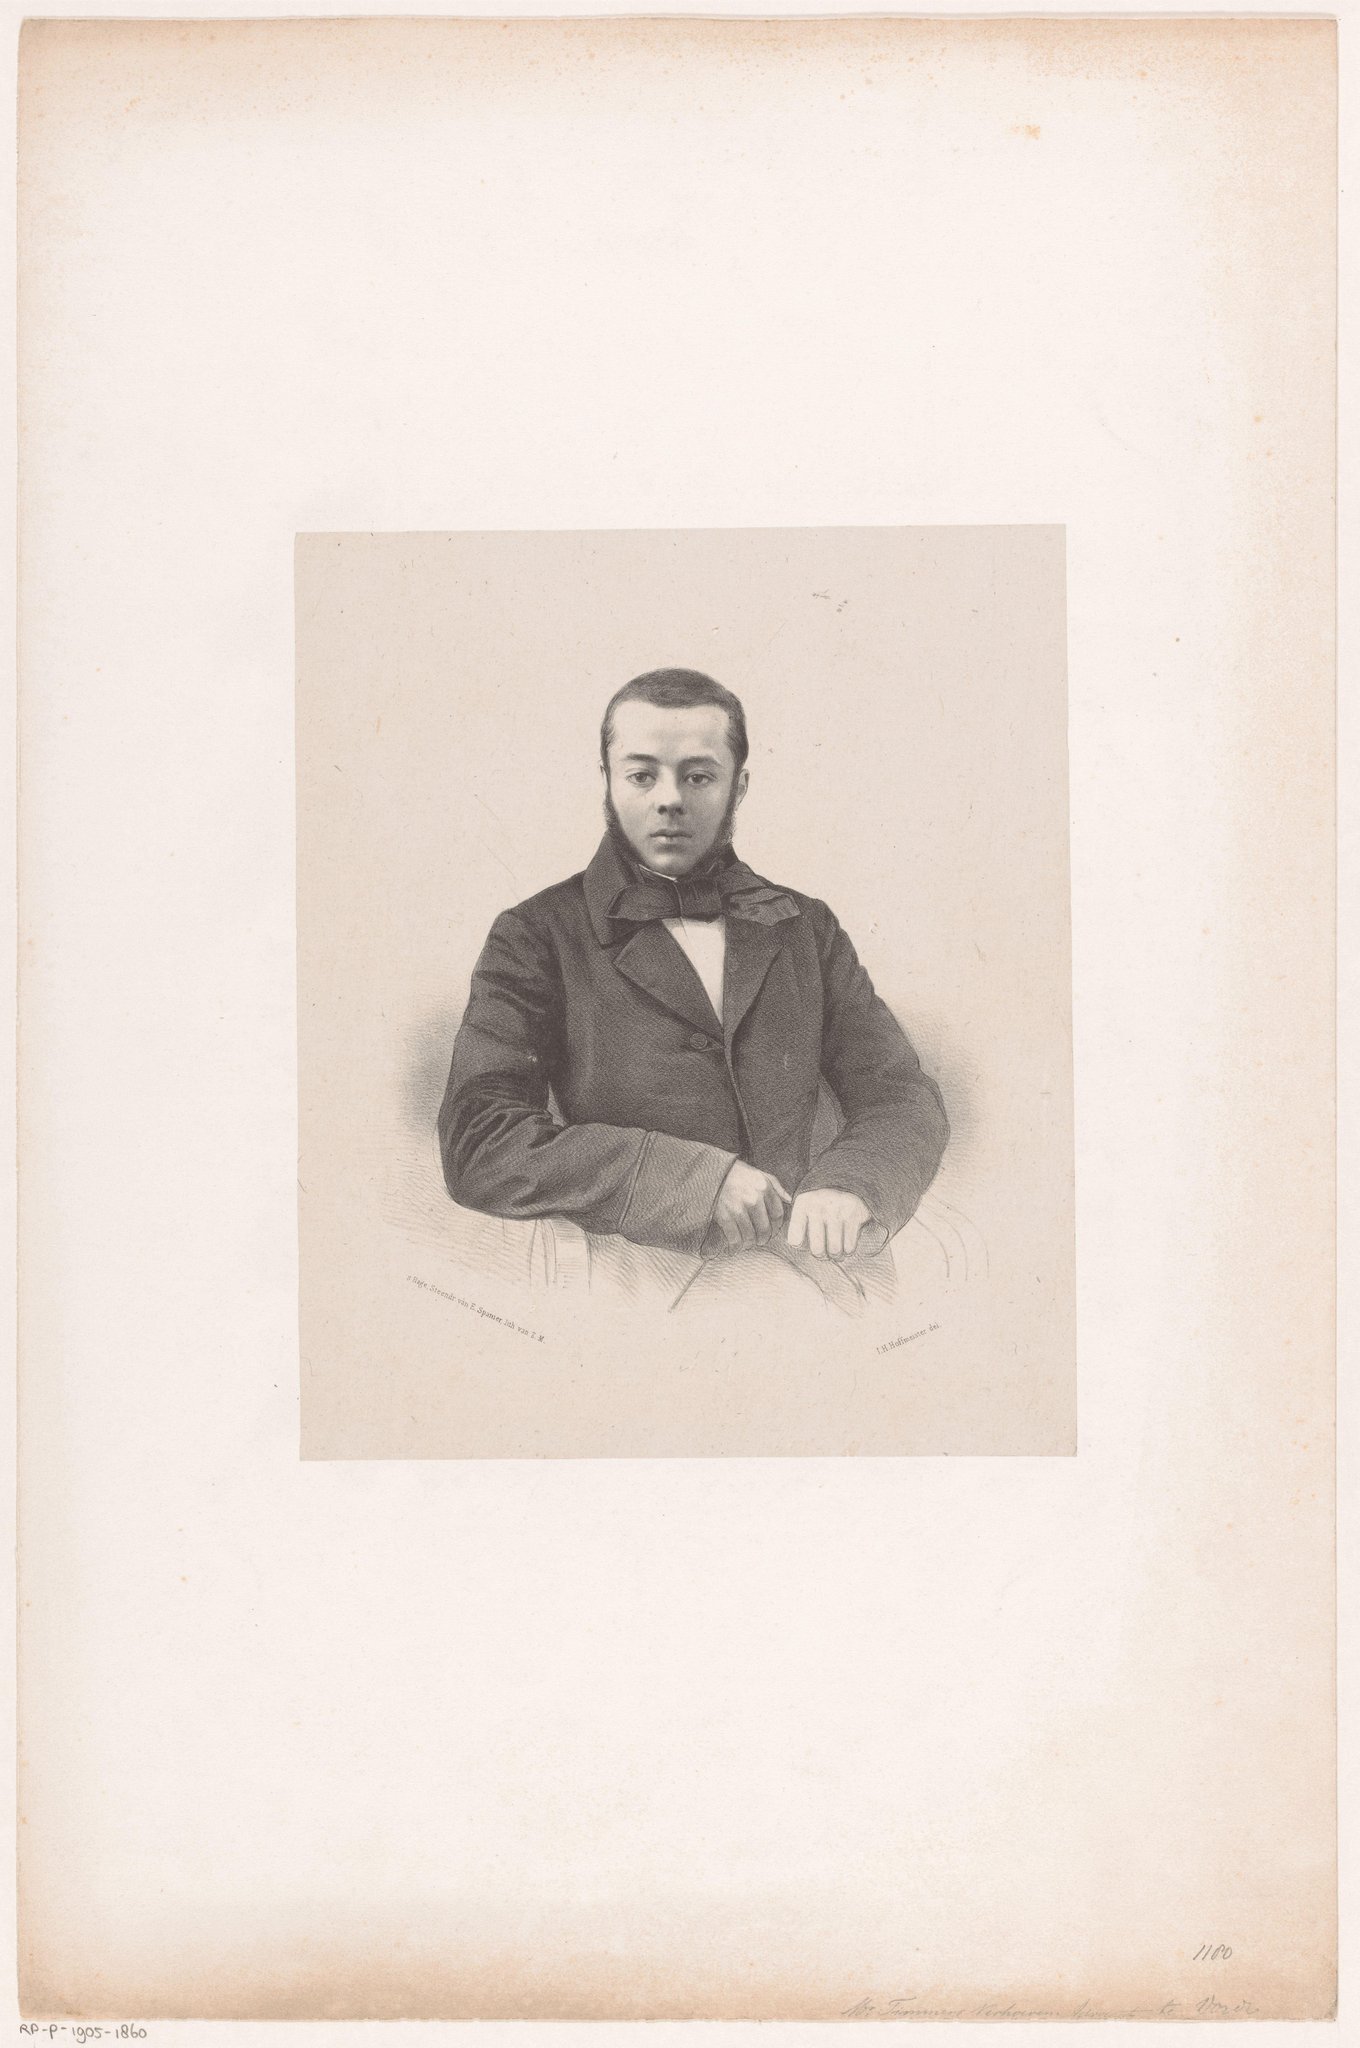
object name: print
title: Portret van Pieter François Timmers Verhoeven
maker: johan hendrik hoffmeister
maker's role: print maker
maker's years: 1823-1904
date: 1851-1883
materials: paper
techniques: lithograph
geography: the hague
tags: dordrecht, historical persons (+ (full) bust portrait)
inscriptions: collector's mark: Lugt 2228